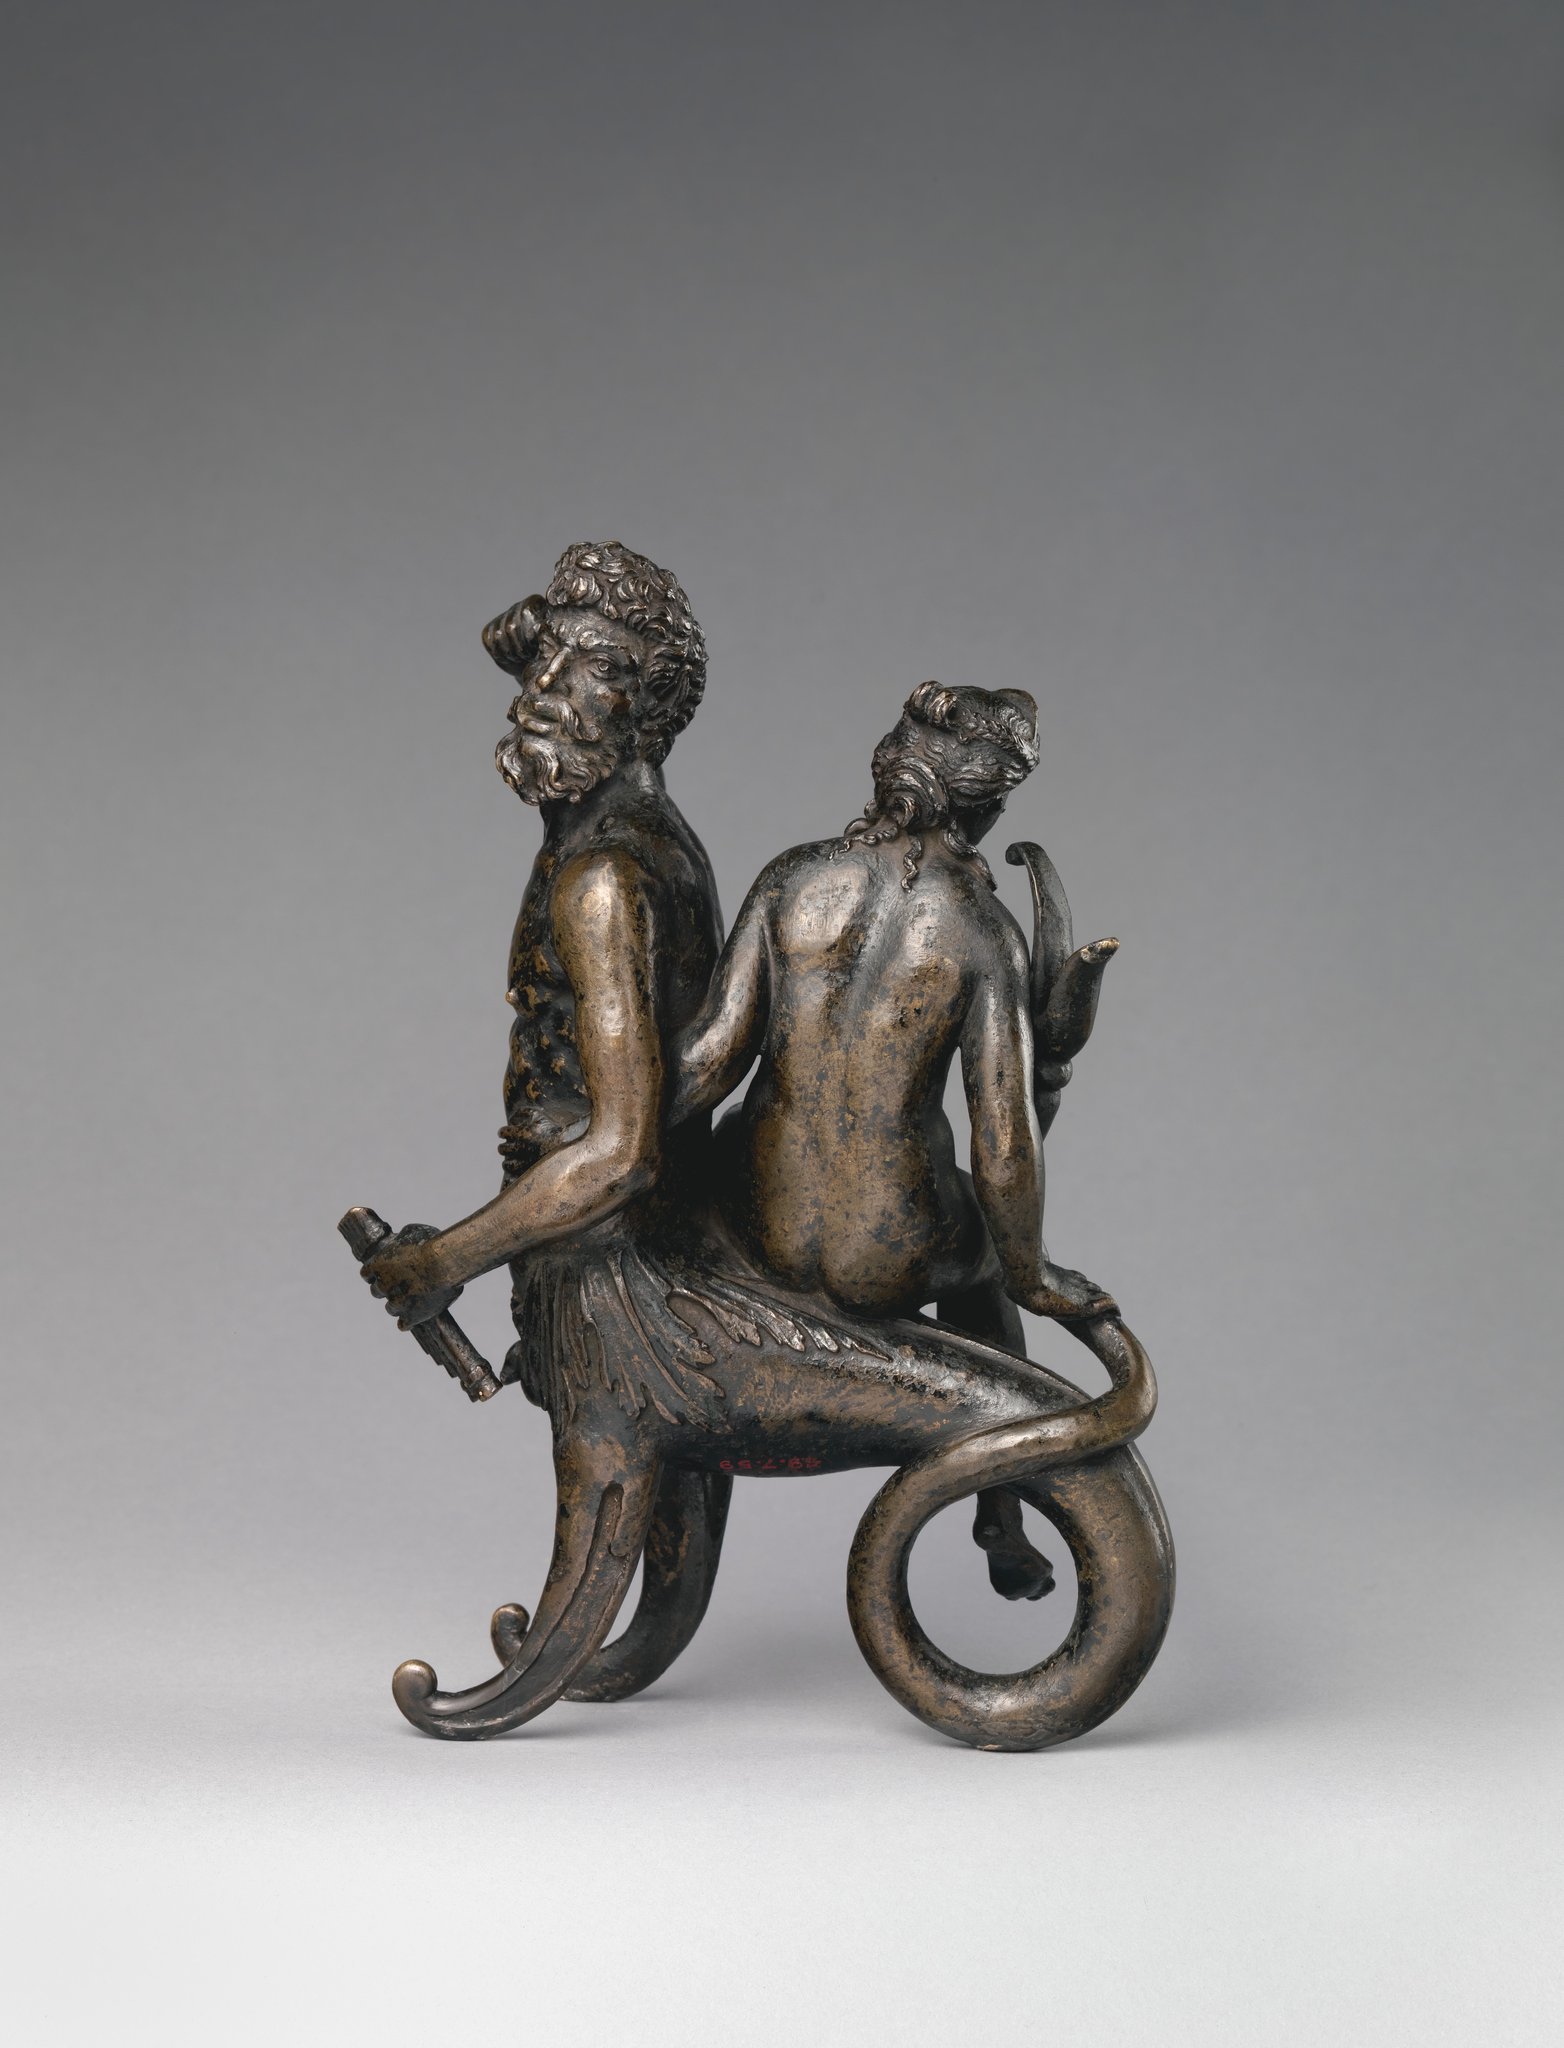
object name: statuette group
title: Triton and Nereid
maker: andrea briosco, called riccio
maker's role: artist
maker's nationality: italian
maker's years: 1470-1532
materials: bronze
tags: triton